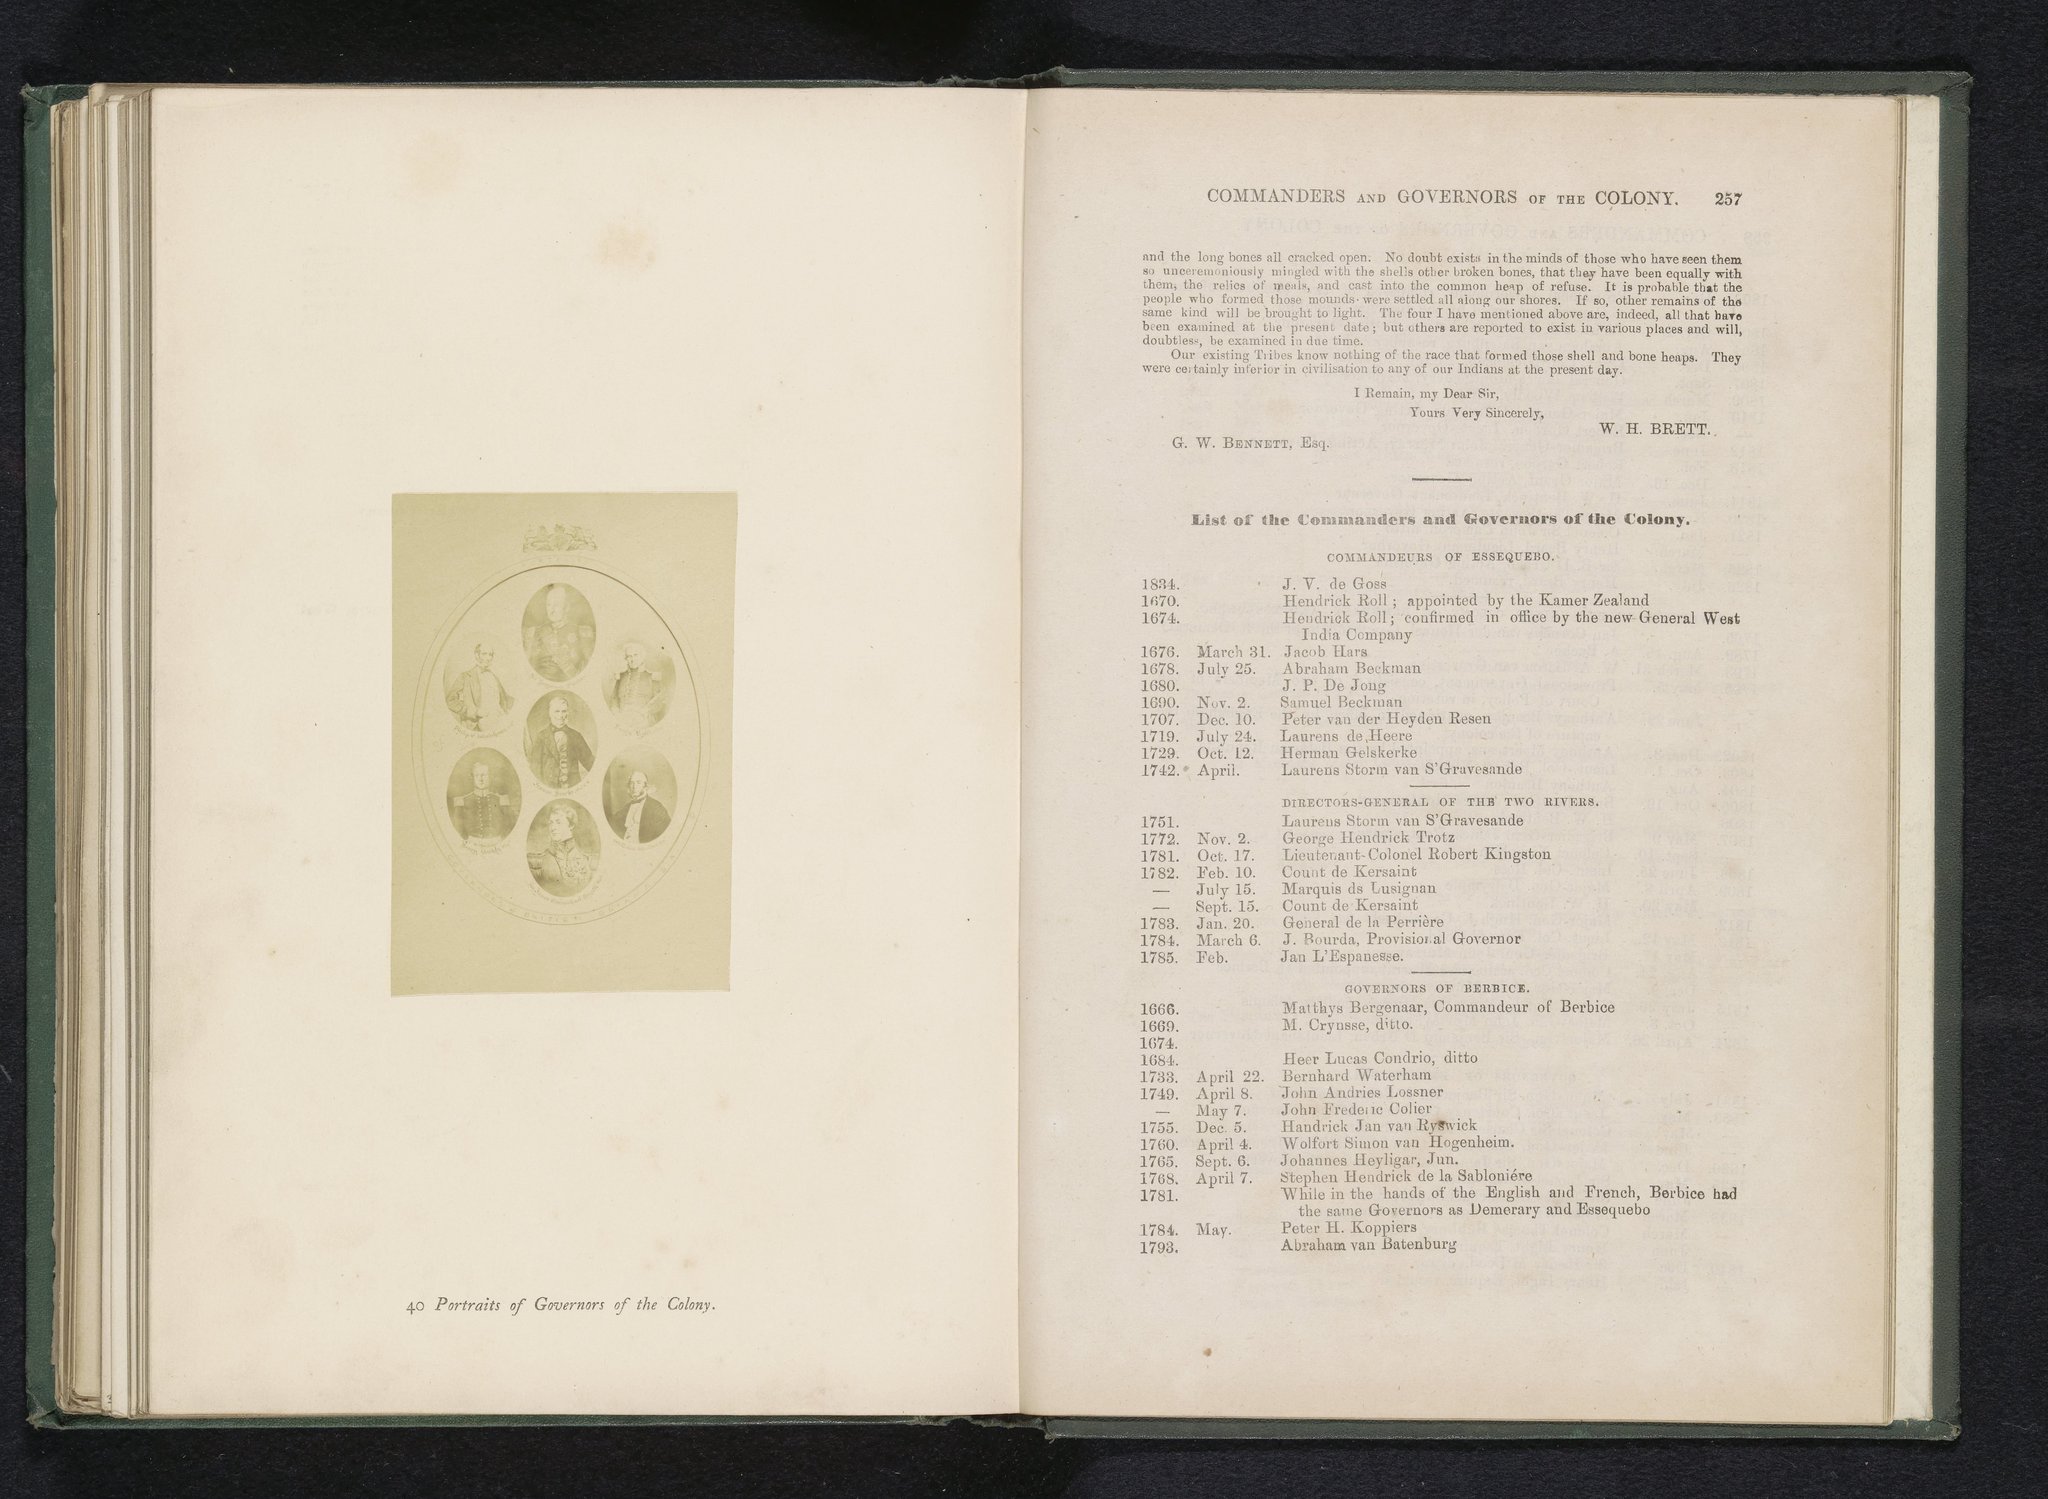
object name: photograph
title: Fotoreproductie van portretten van zeven Britse gouverneurs in Guyana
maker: Anonymous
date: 1856-1866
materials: photographic support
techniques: albumen print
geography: guyana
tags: colonial governor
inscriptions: number: ‘40’